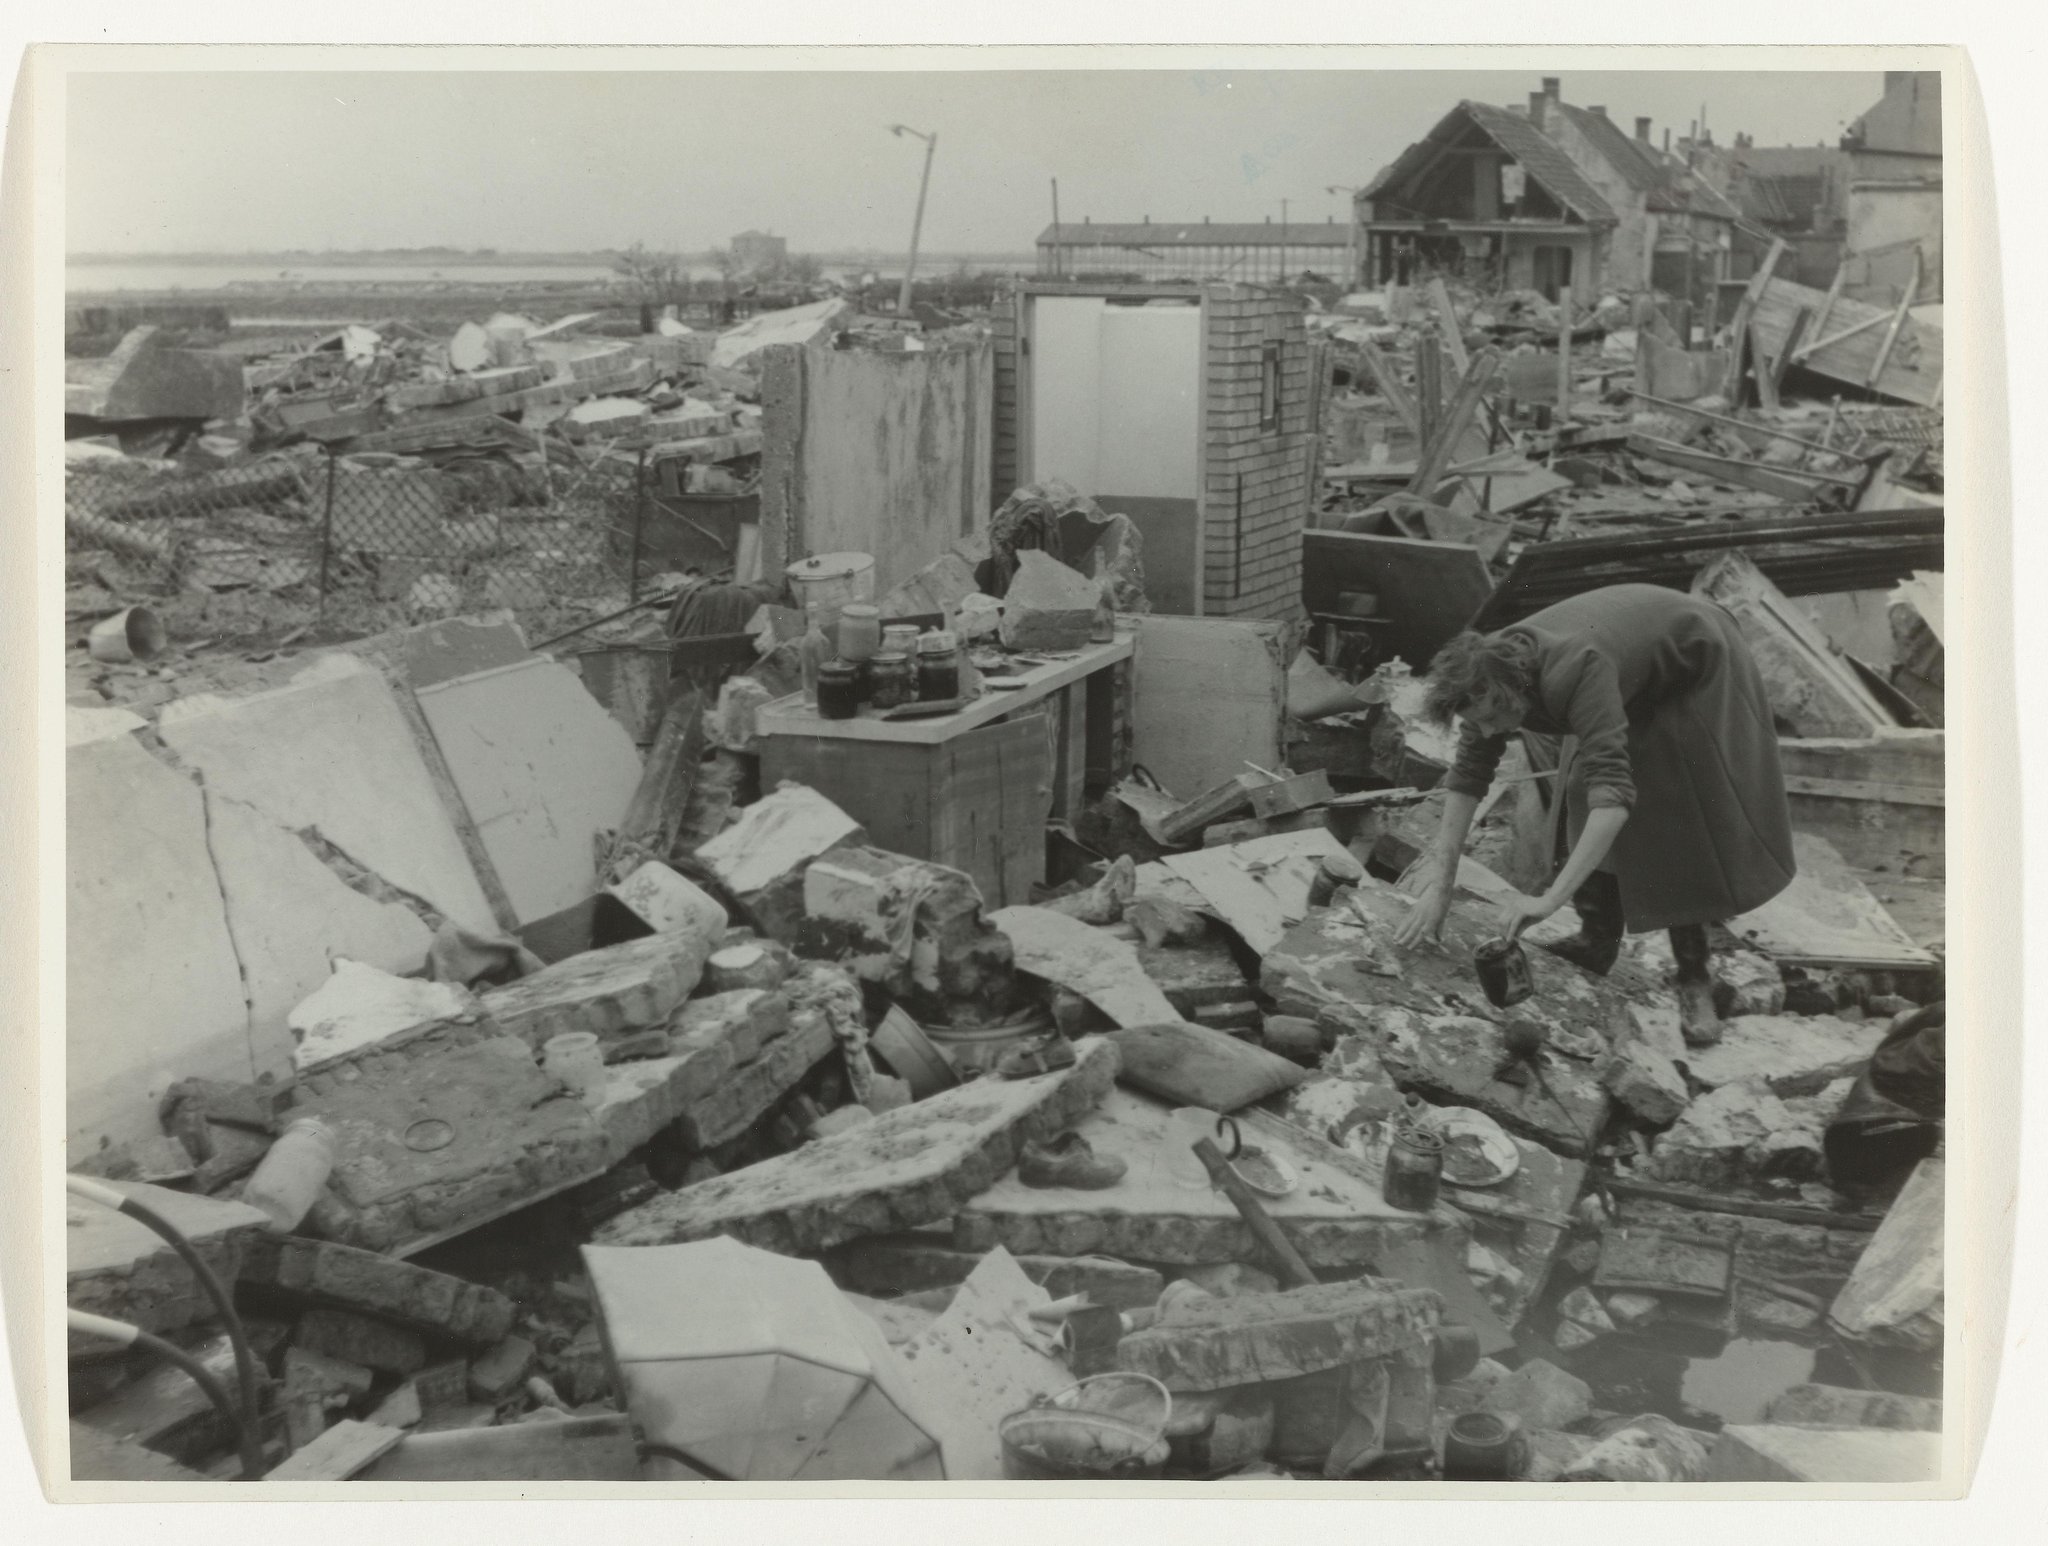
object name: photograph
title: Na de Watersnoodramp van 1953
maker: Anonymous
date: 1953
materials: photographic support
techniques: photography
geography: zeeland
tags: zeeland, north sea flood of 1953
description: Een vrouw zoekt naar bruikbare spullen tussen het puin van huizen die werden vernield bij de watersnood van februari 1953.